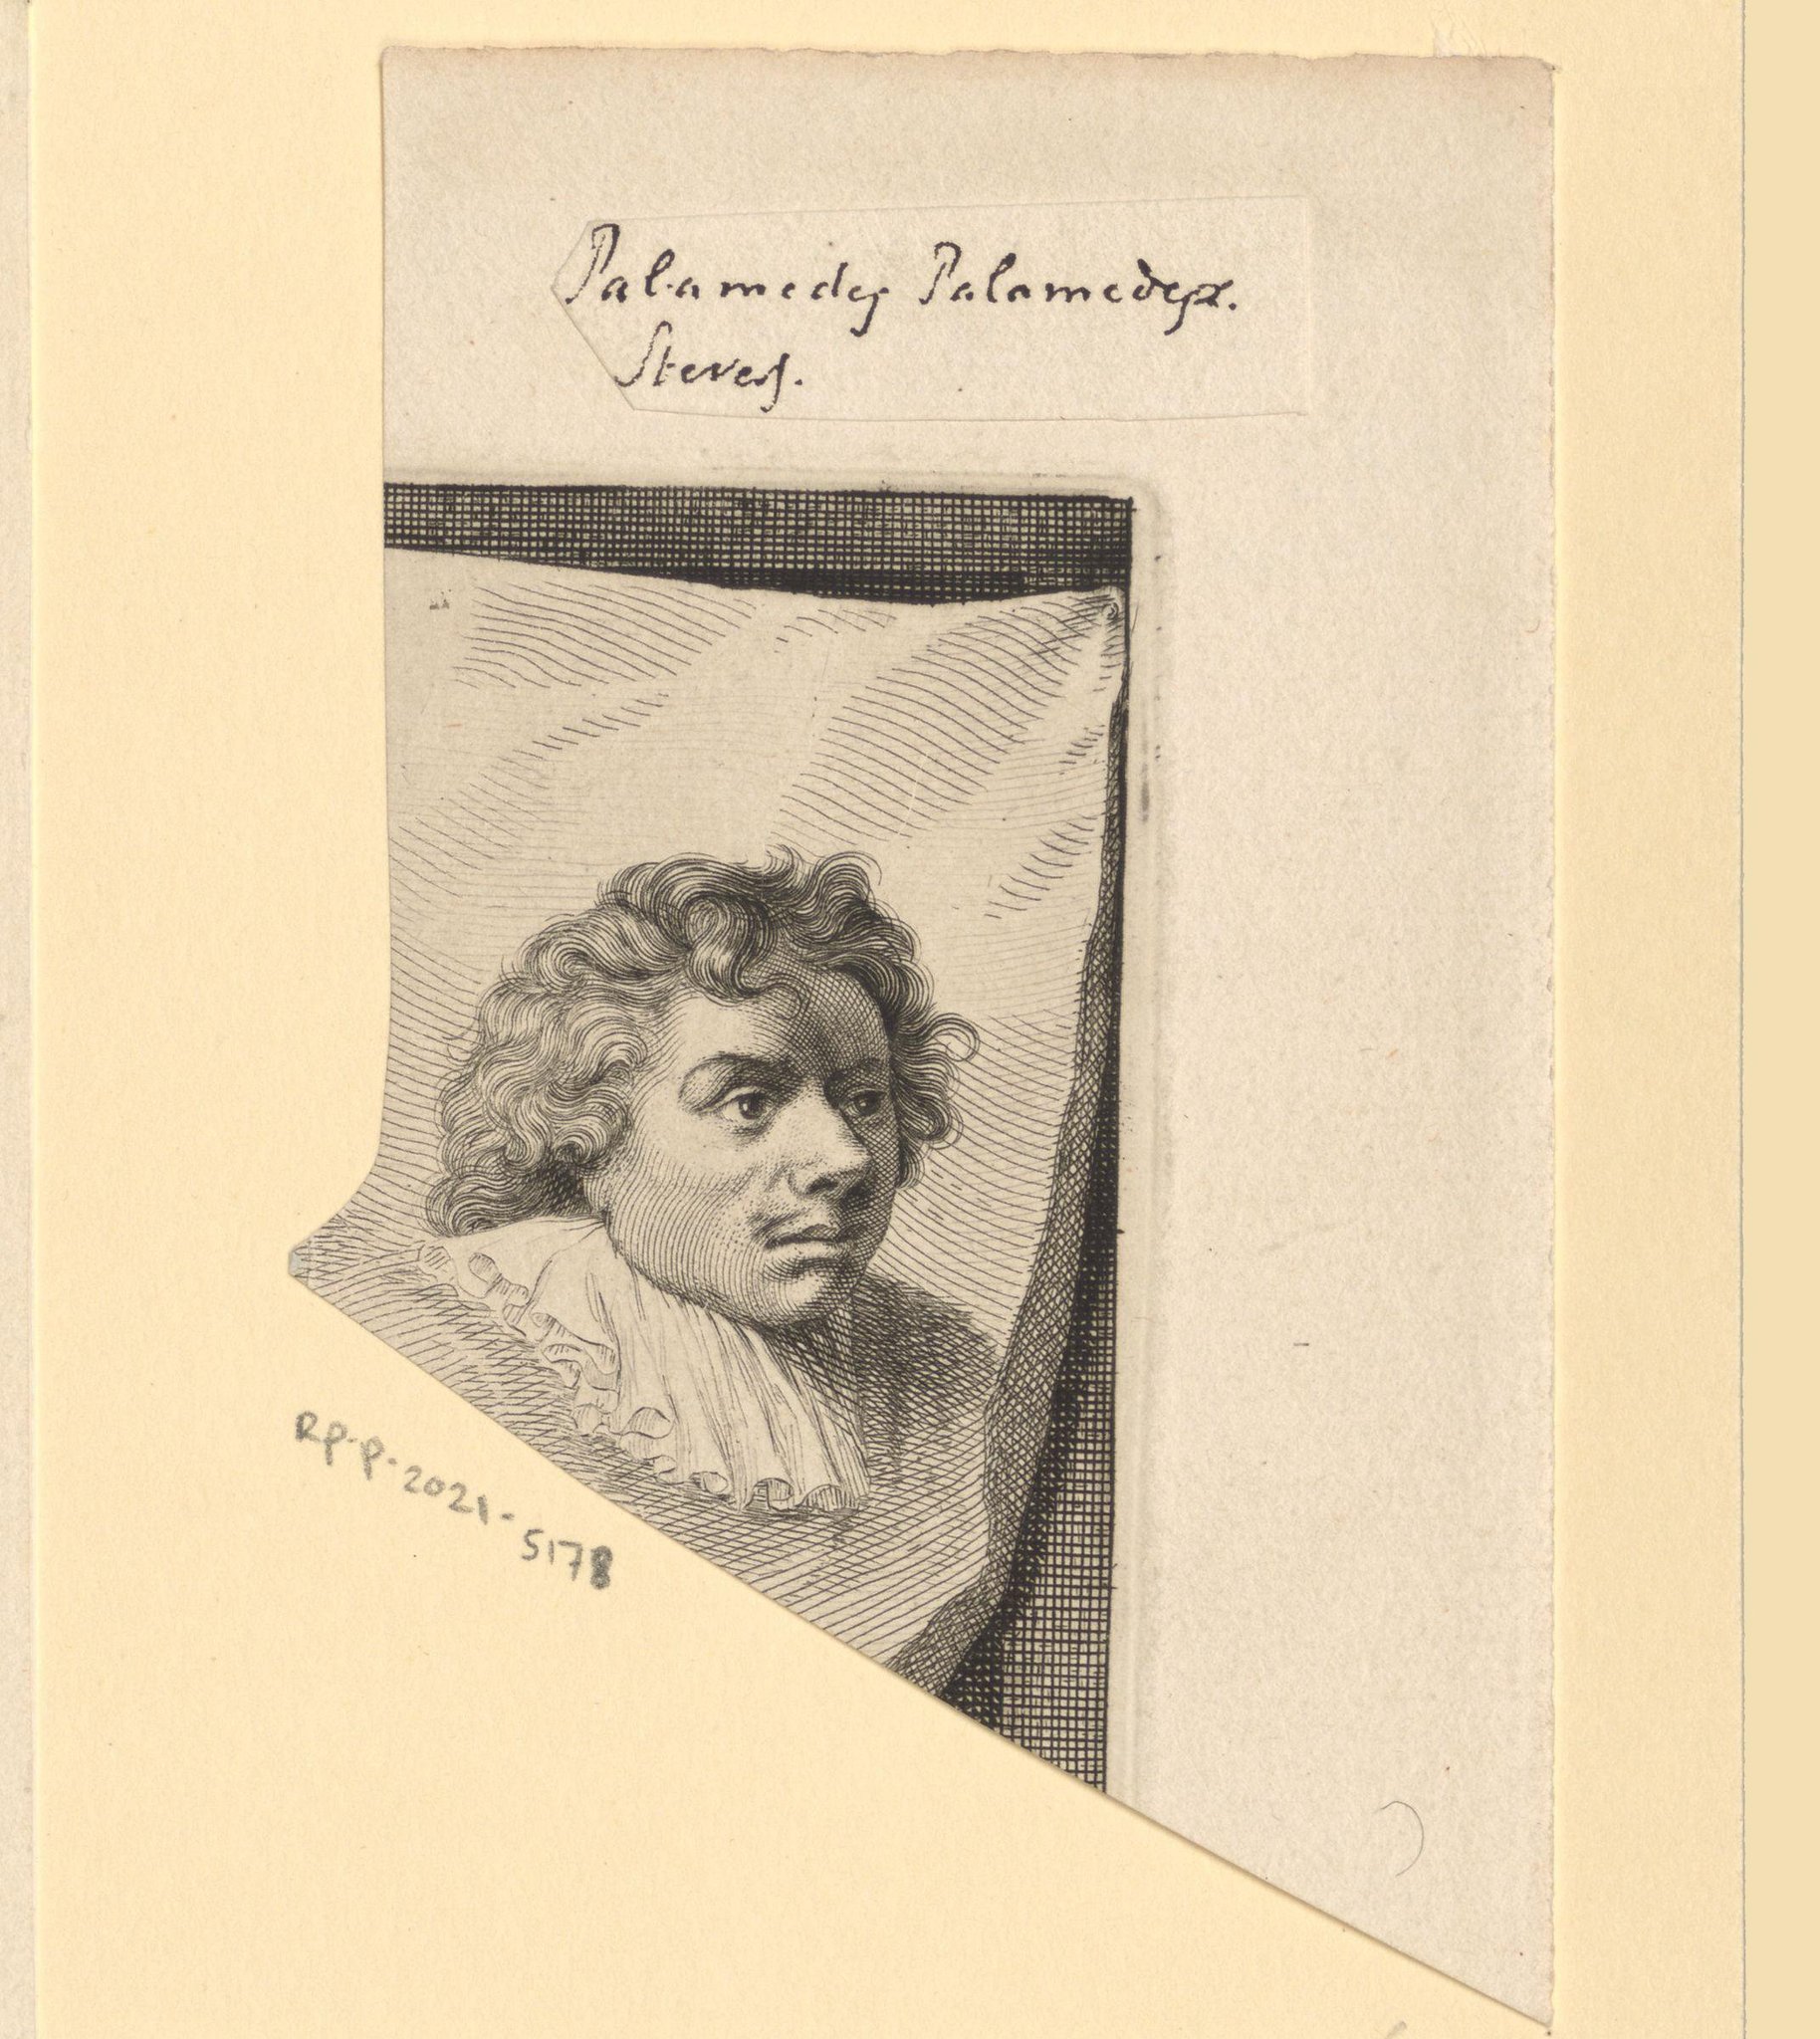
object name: print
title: Portret van Palamedes Palamedesz. I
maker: jacob houbraken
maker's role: draughtsman, print maker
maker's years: 1698-1780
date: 1729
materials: paper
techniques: engraving, etching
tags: delft, painter, palamedes palamedesz. (i), adult man, historical persons, portrait, self-portrait of painter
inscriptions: collector's mark: Lugt 2228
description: Deze prent is mogelijk een uitgeknipt detail van een prent uit: Weyerman, Jacob Campo. De levens-beschryvingen der Nederlandsche konst-schilders en konst-schilderessen (...). 4 dln. Den Haag: weduwe Engelbrecht Boucquet, Hendrik Scheurleer, Frederik Bouquet en Jan de Jongh, 1729, dl. 1. Eerdere staat van deze prent is gebruikt in: Houbraken, Arnold. De groote schouburgh der Nederlantsche konstschilders en schilderessen (...). Amsterdam: Arnold Houbraken, 1718, dl. 1.